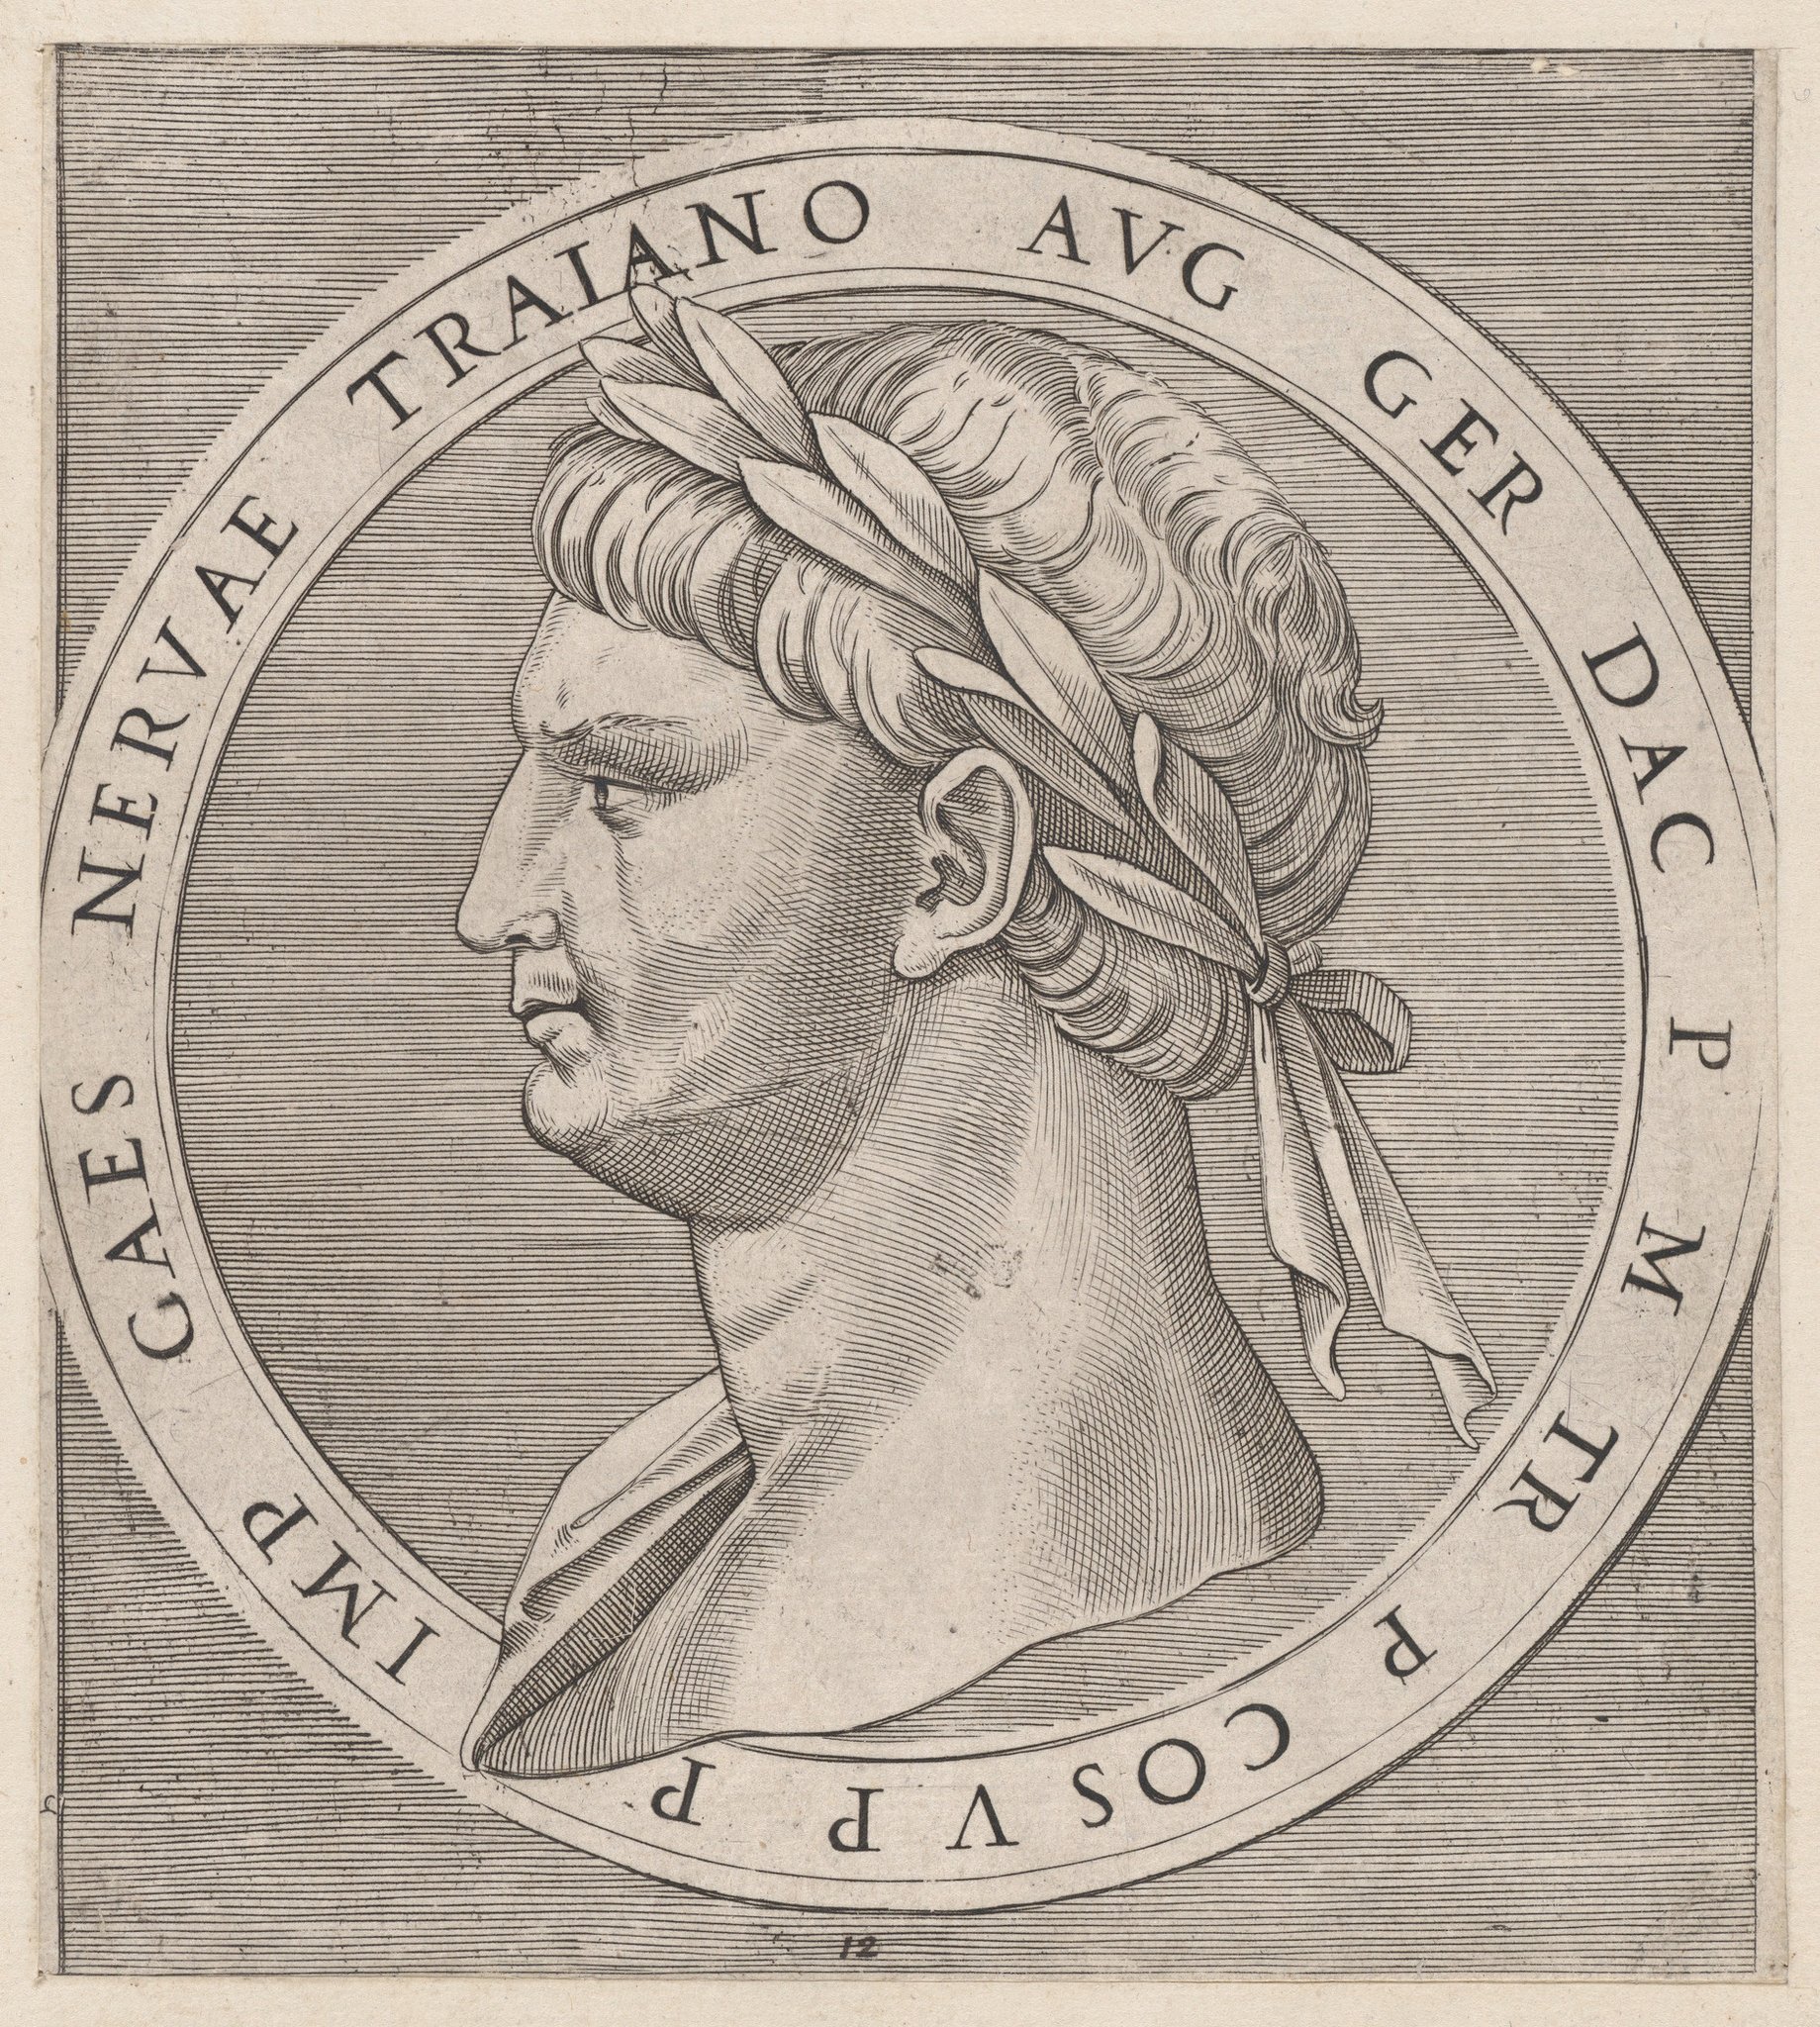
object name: print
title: Nerva, from The Twelve Caesars, from "Speculum Romanae Magnificentiae"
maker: marcantonio raimondi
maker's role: artist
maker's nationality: italian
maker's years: 1475-1534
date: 1500-1534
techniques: engraving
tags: men,profiles